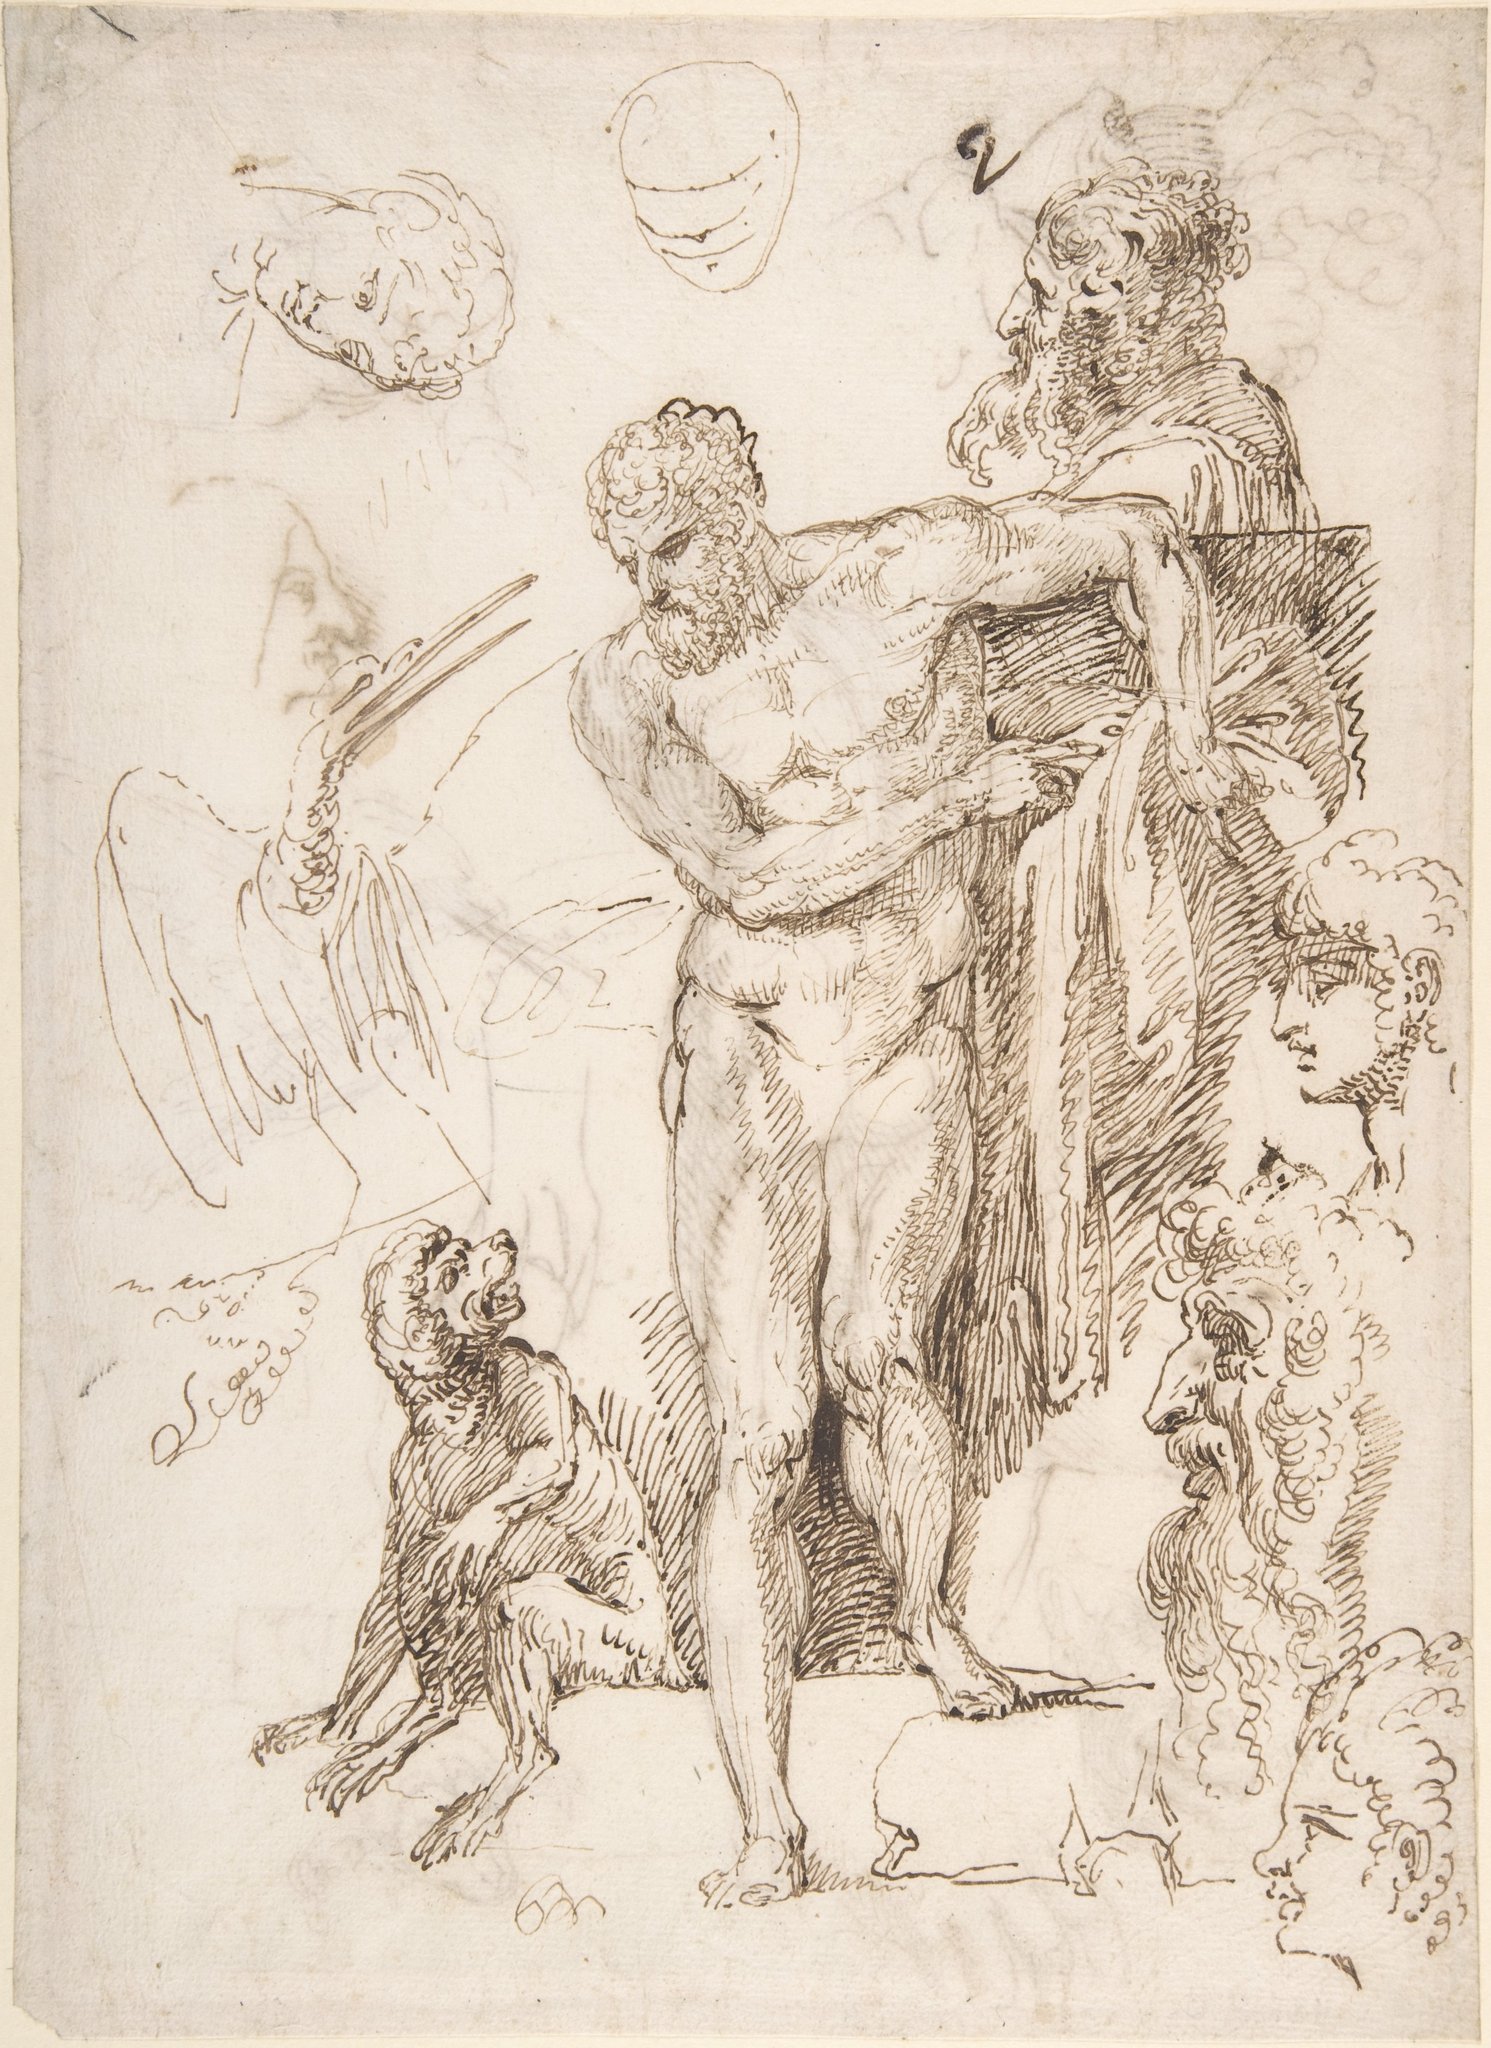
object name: drawing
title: Studies and Sketches for Figures: Standing Male Nude in Frontal View, Male Heads, Seated Monkey, and a Long-Beaked Bird (a Stork?) (recto); Figure Studies: Back View of Standing Male and Female Heads, a Flying Long-Beaked Bird, etc. (verso)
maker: agostino carracci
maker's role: artist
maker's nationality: italian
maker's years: 1557-1602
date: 1557-1602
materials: chalk, ink, drawing material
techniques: pen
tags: birds,male nudes,women,monkeys